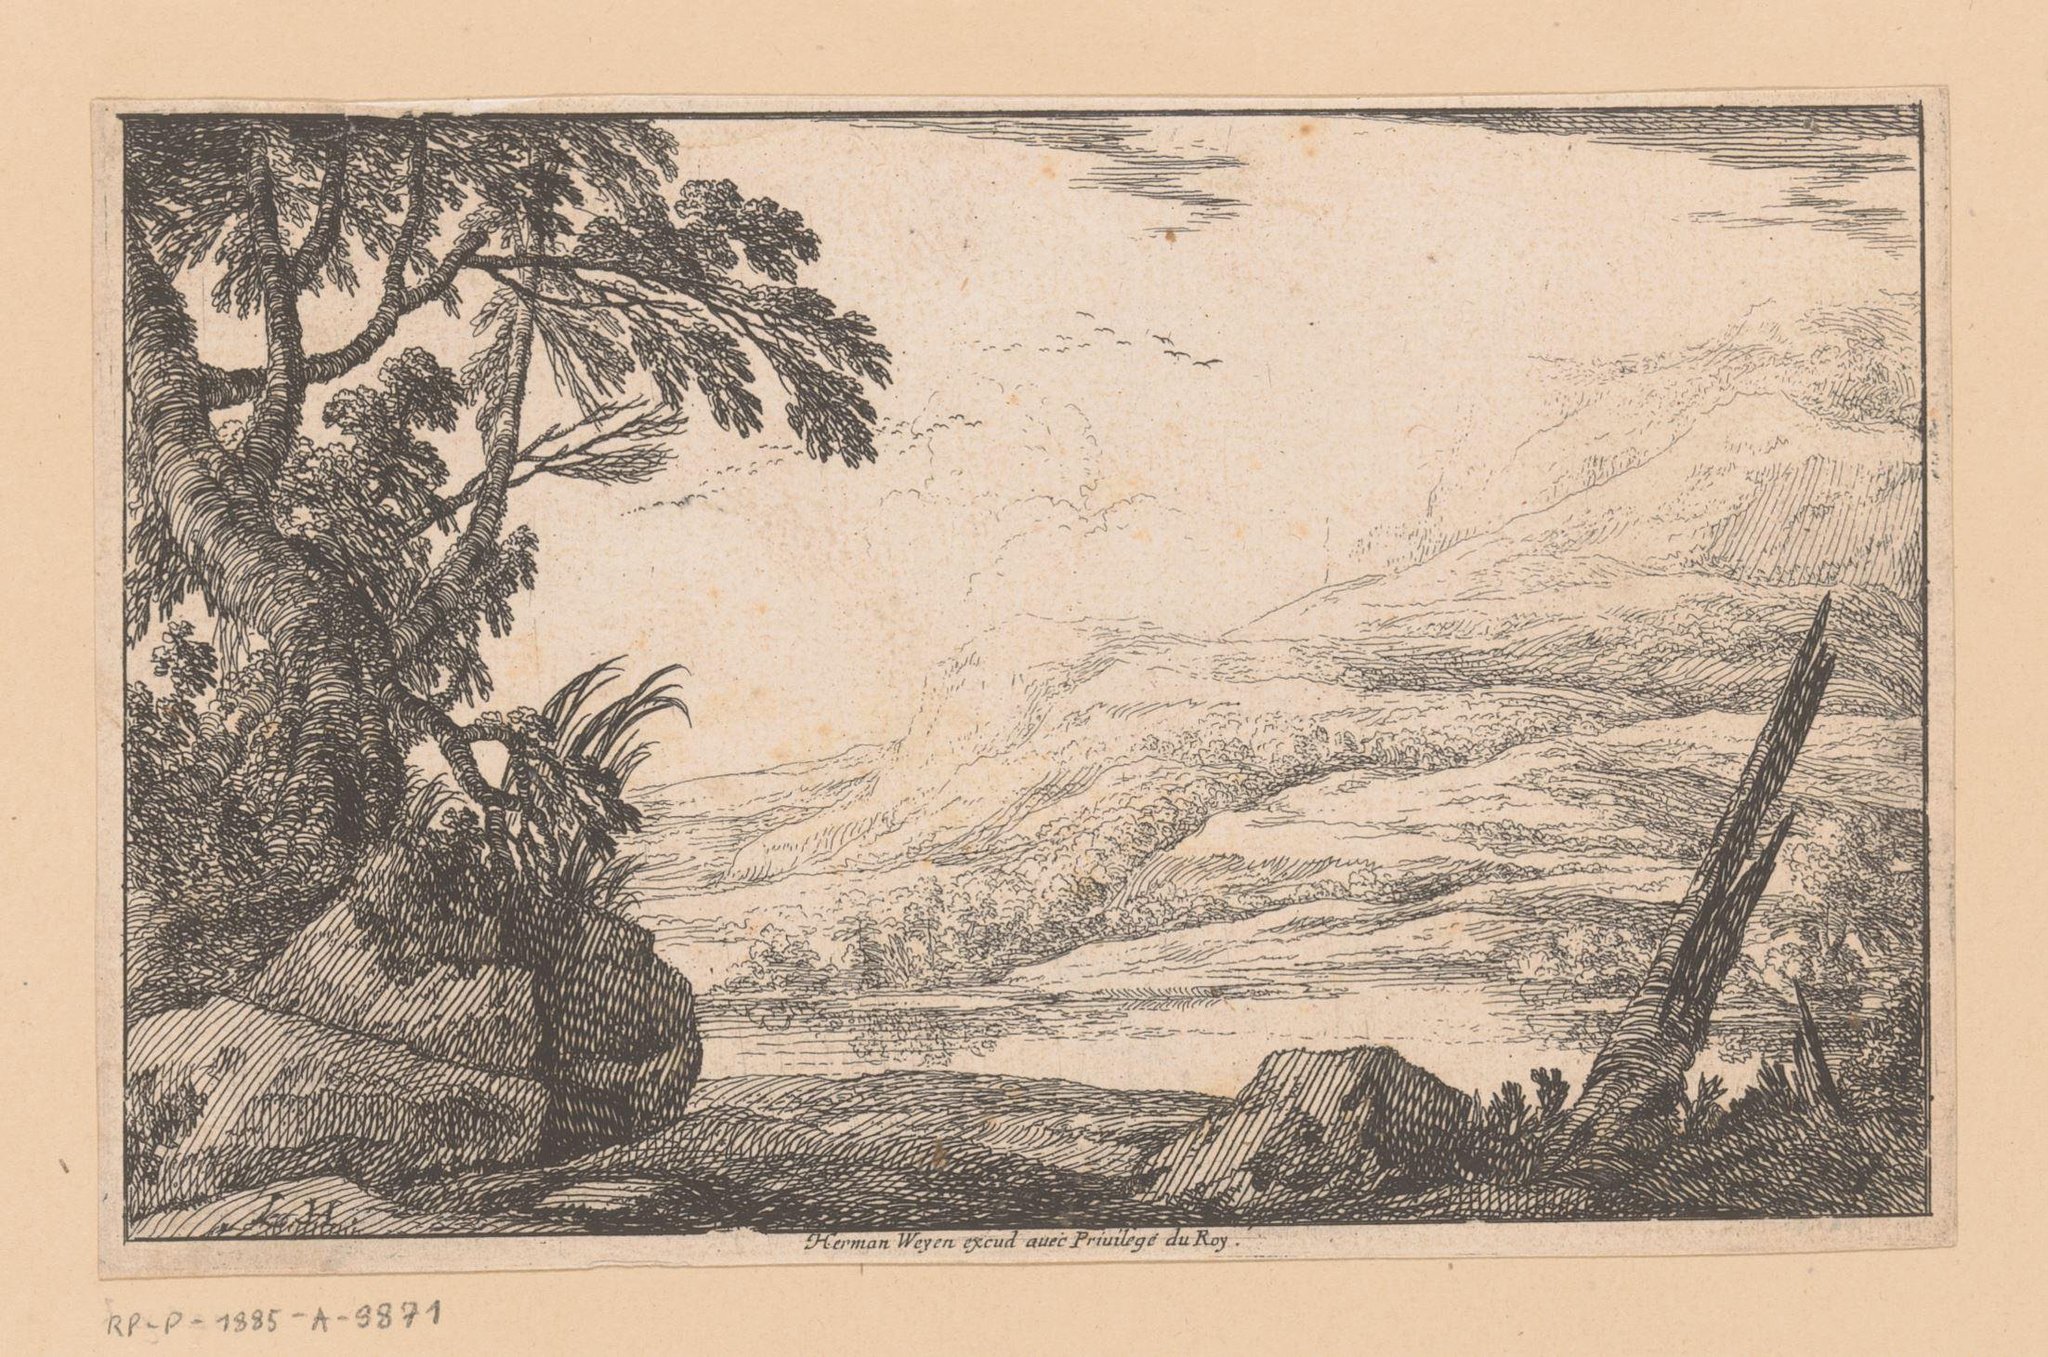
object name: print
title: Landschap met zicht op een berg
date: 1616-1656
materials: paper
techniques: etching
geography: paris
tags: mountains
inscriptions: collector's mark: Lugt 2228